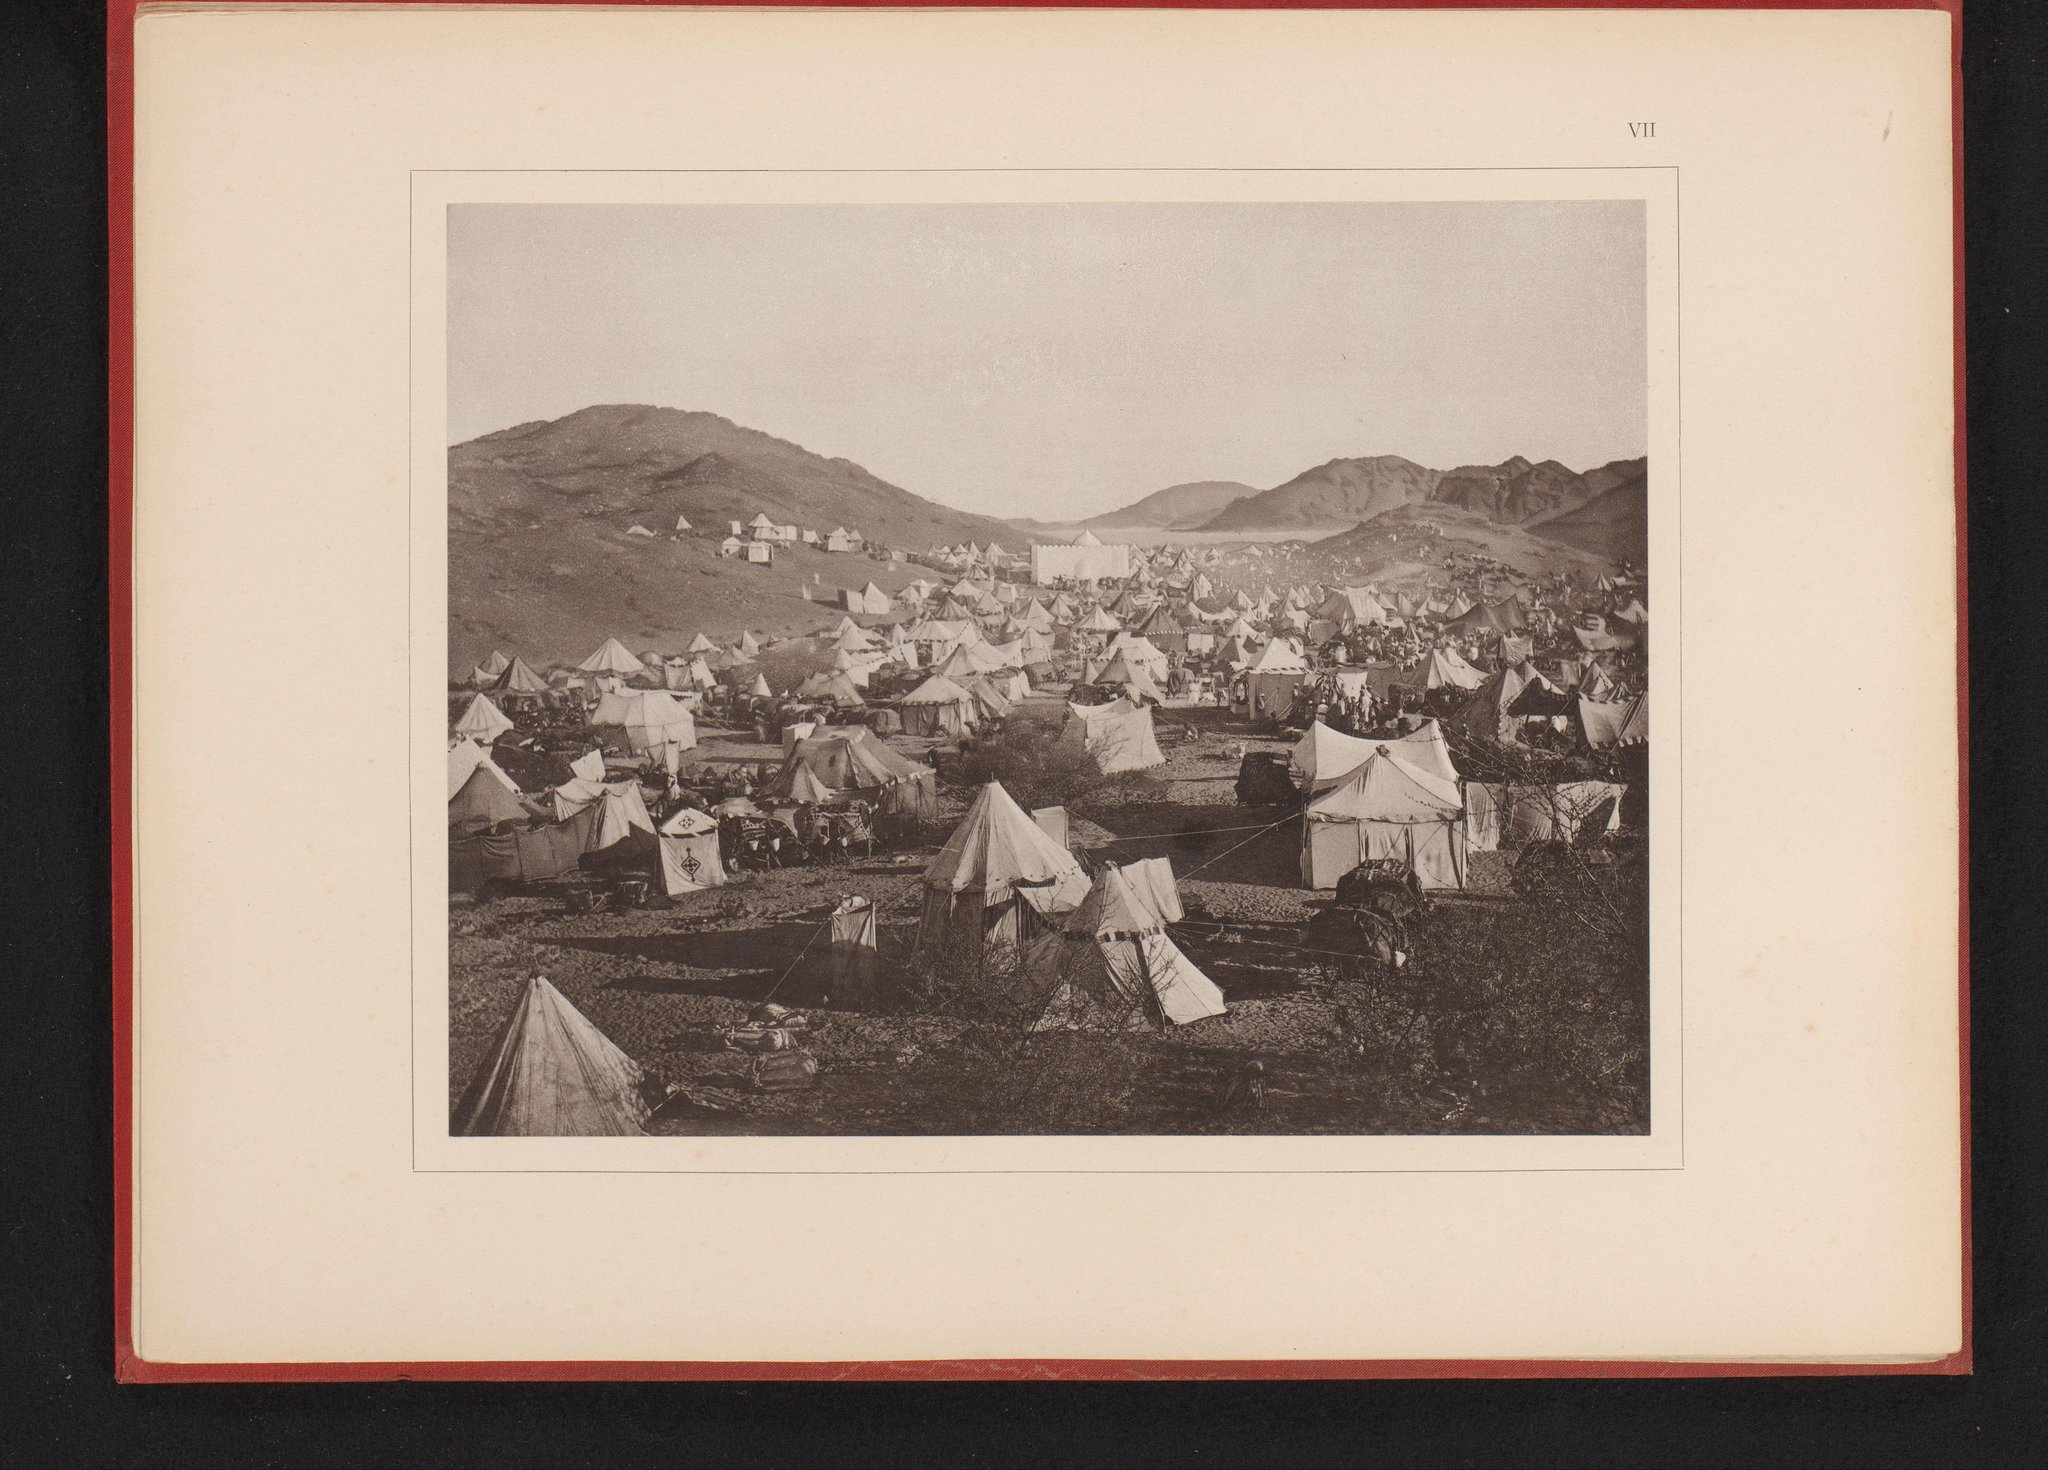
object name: photomechanical print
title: Das Grab der Sittana Mèjmunah und Lager dorthin gepilgerter Mekkaner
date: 1889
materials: cardboard, paper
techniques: photograph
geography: mecca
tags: grave, tomb, tent-camp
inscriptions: number: ‘VII’